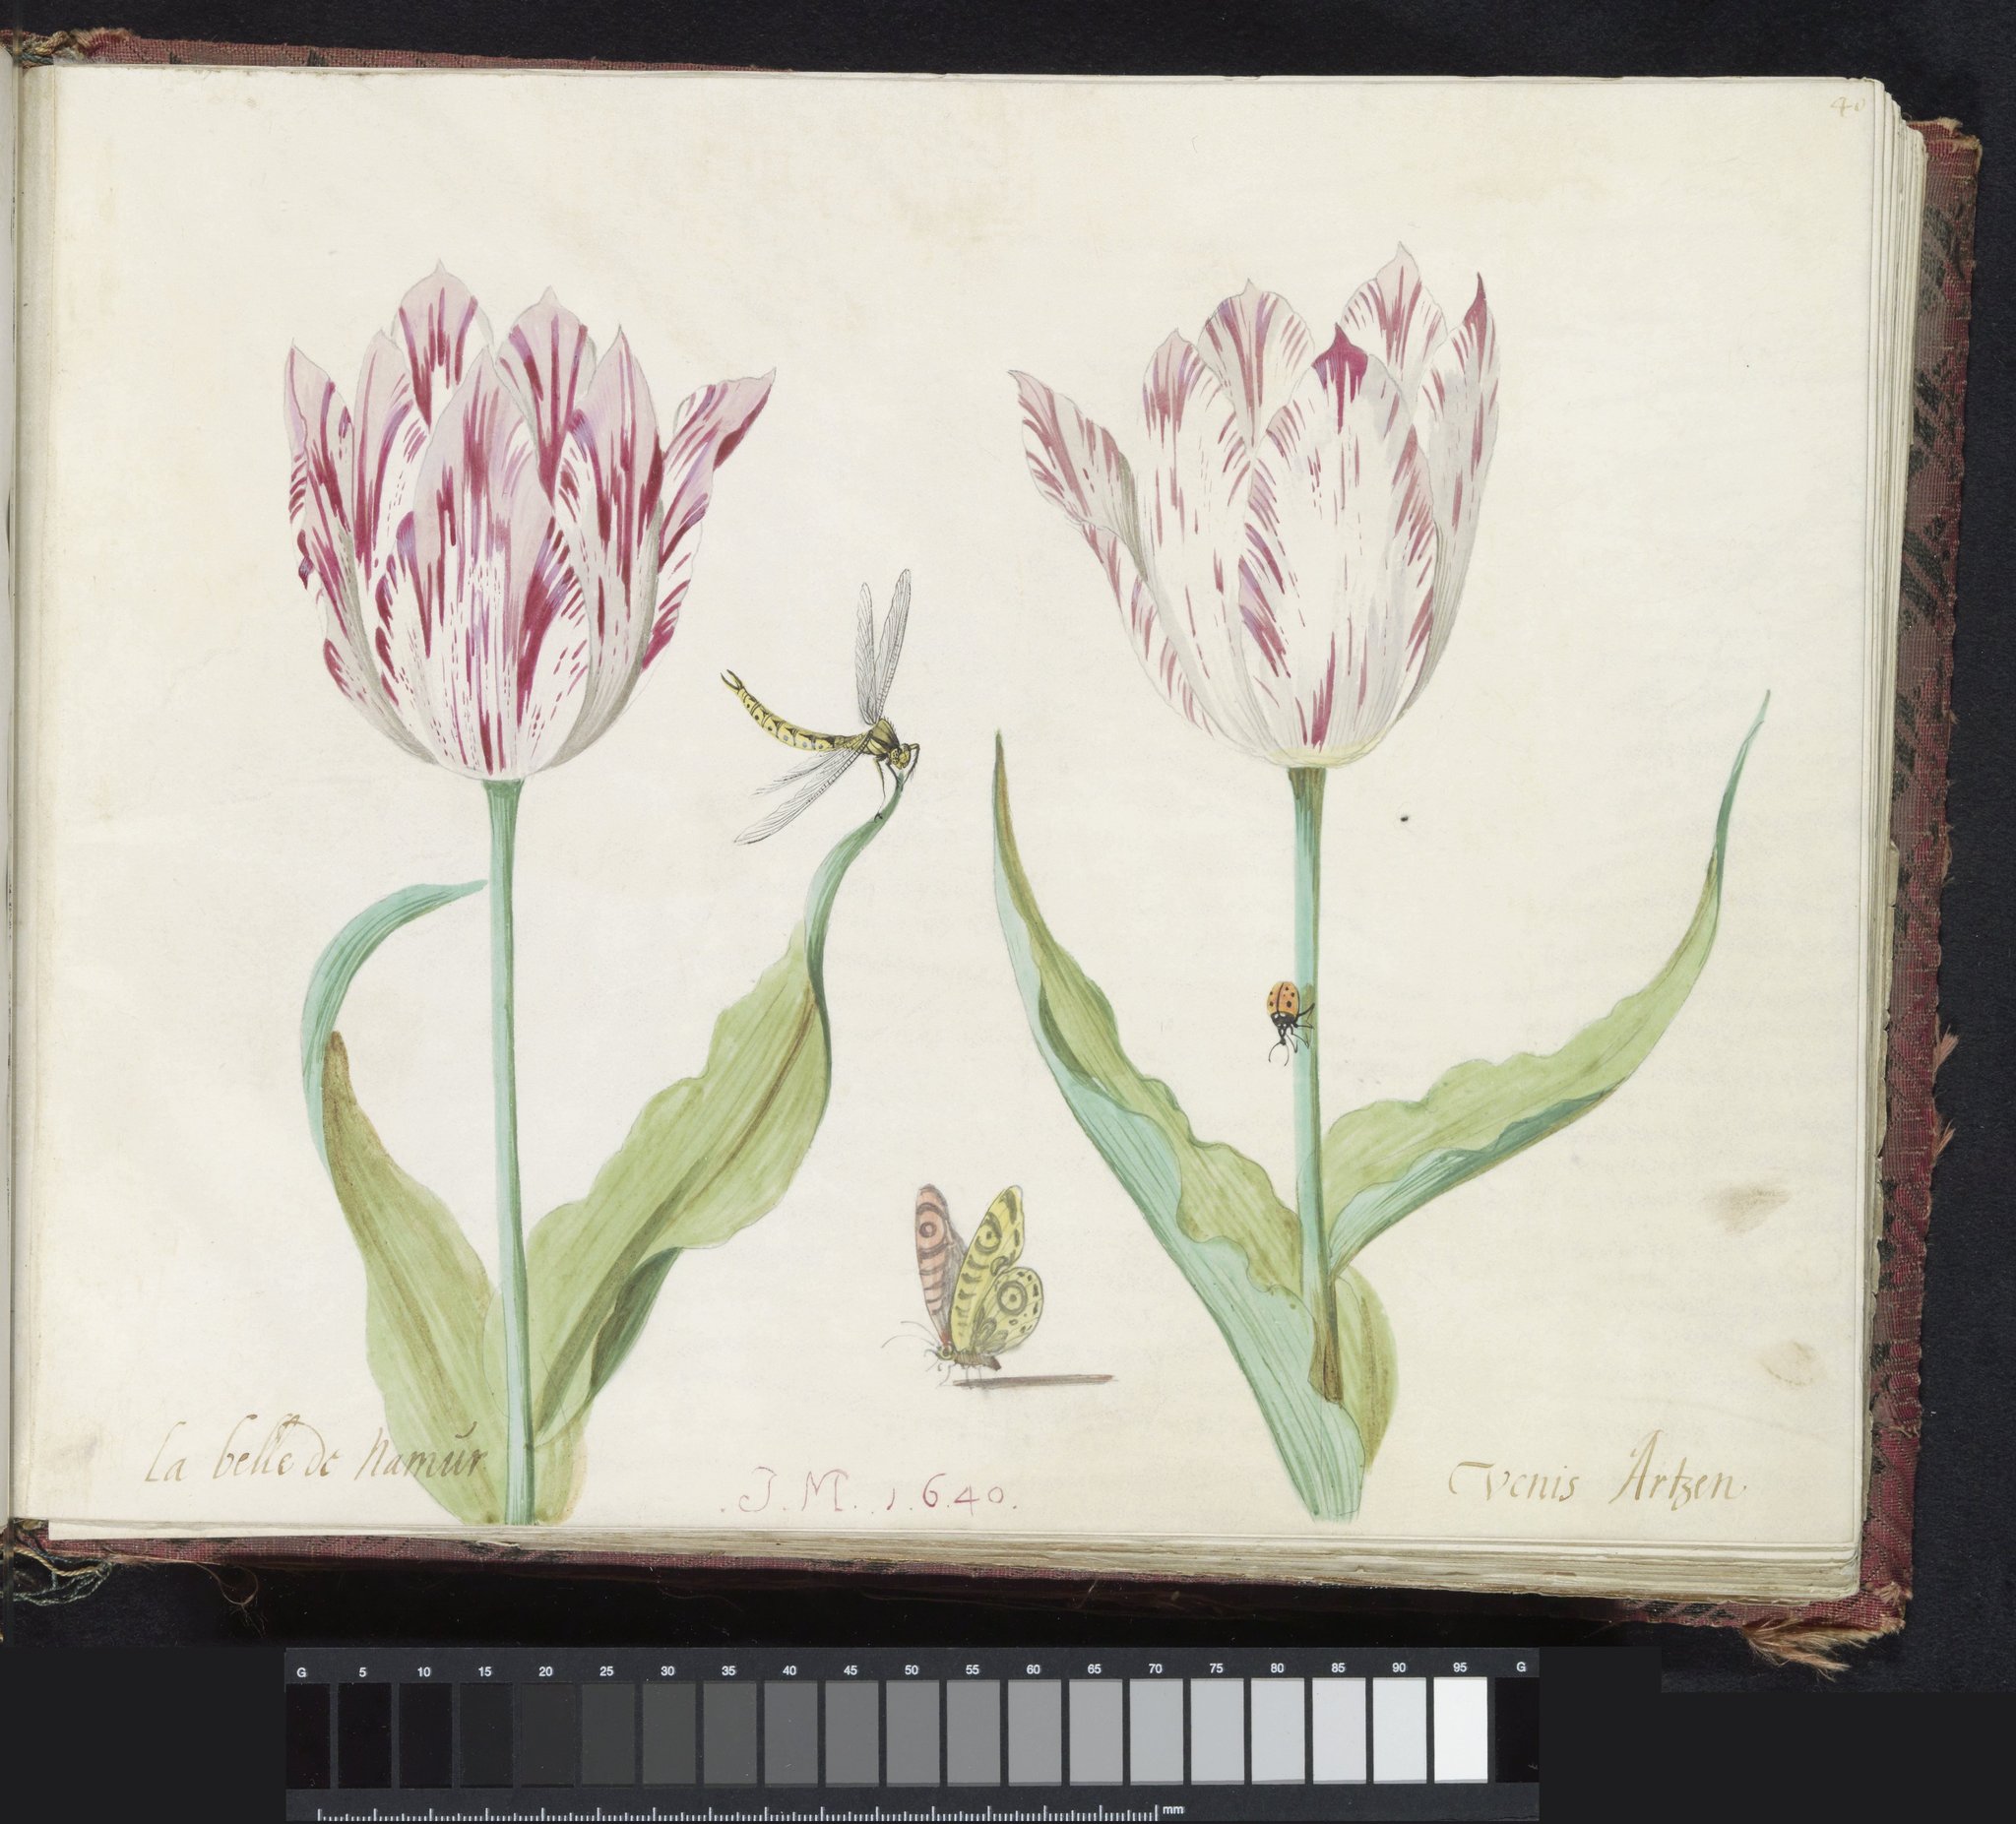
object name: album leaf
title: La belle de Namur / Venis Artzen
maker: jacob marrel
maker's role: draughtsman, painter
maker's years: 1614-1681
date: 1640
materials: paint, parchment, pencil, watercolor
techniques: brush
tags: insects: dragon-fly, insects: butterfly, flowers: tulip, insects: beetle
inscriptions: date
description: De tekening maakt deel uit van een album.